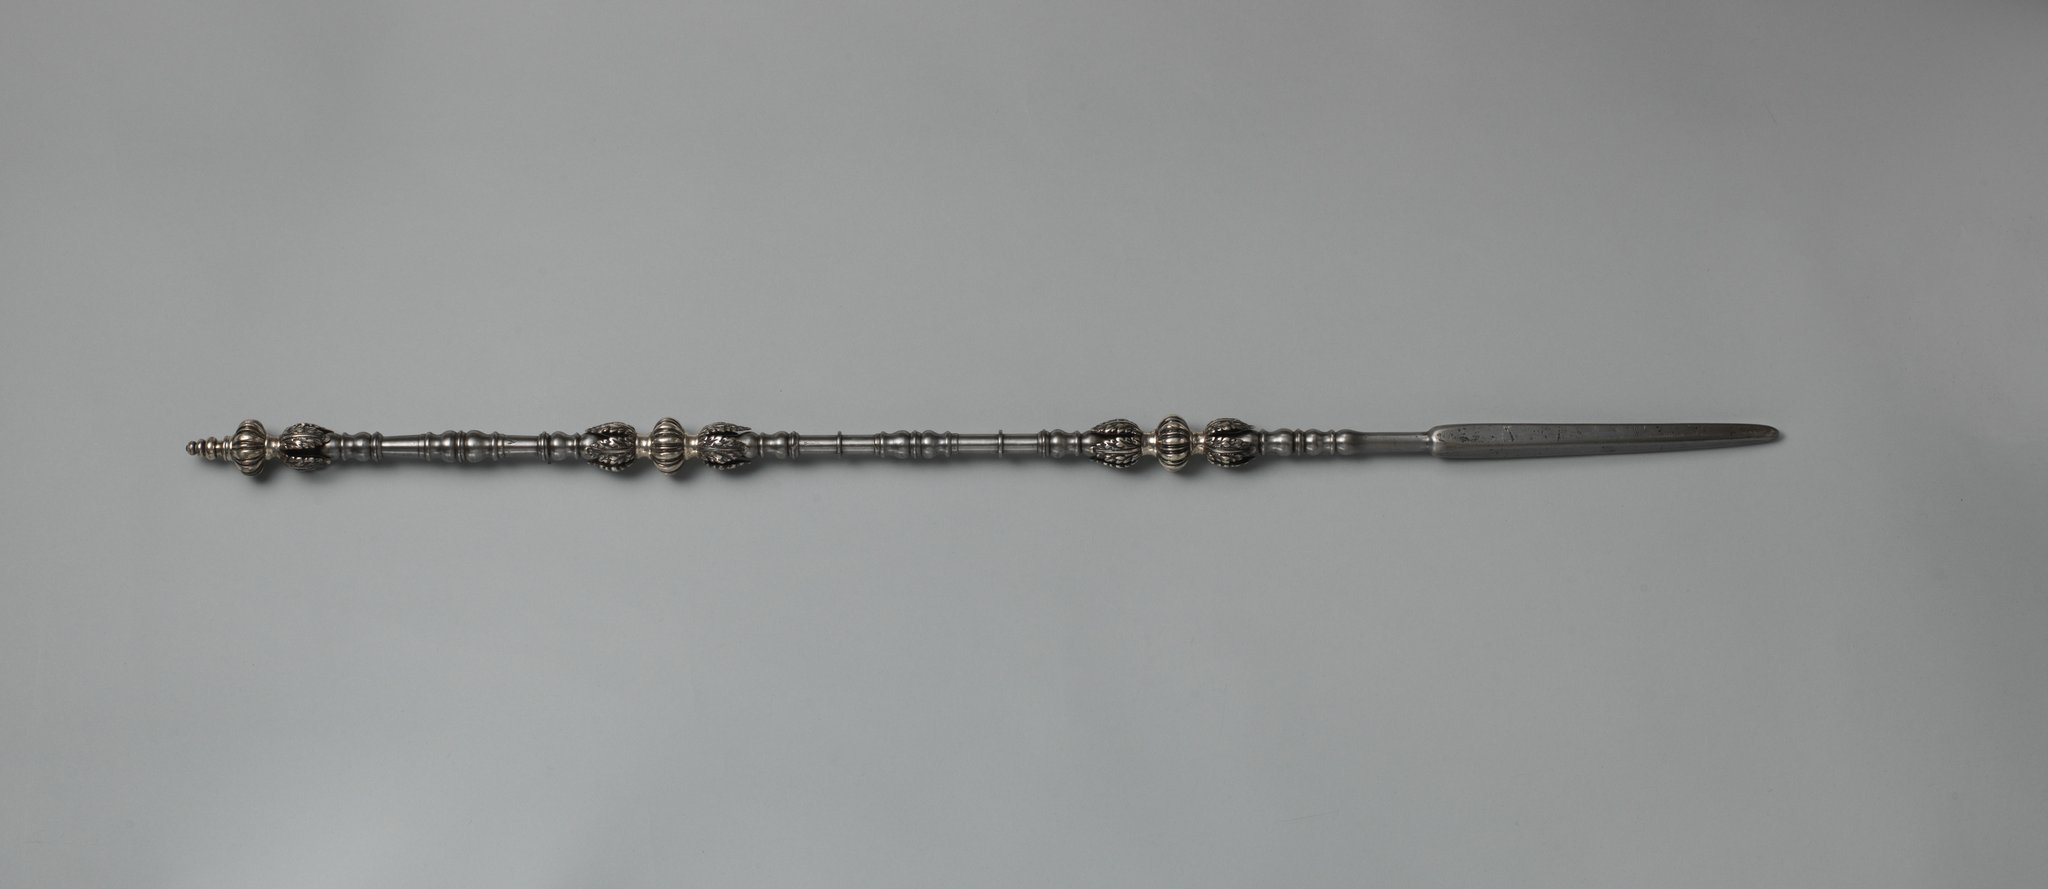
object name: poker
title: Poker (part of a set)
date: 1675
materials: iron, silver